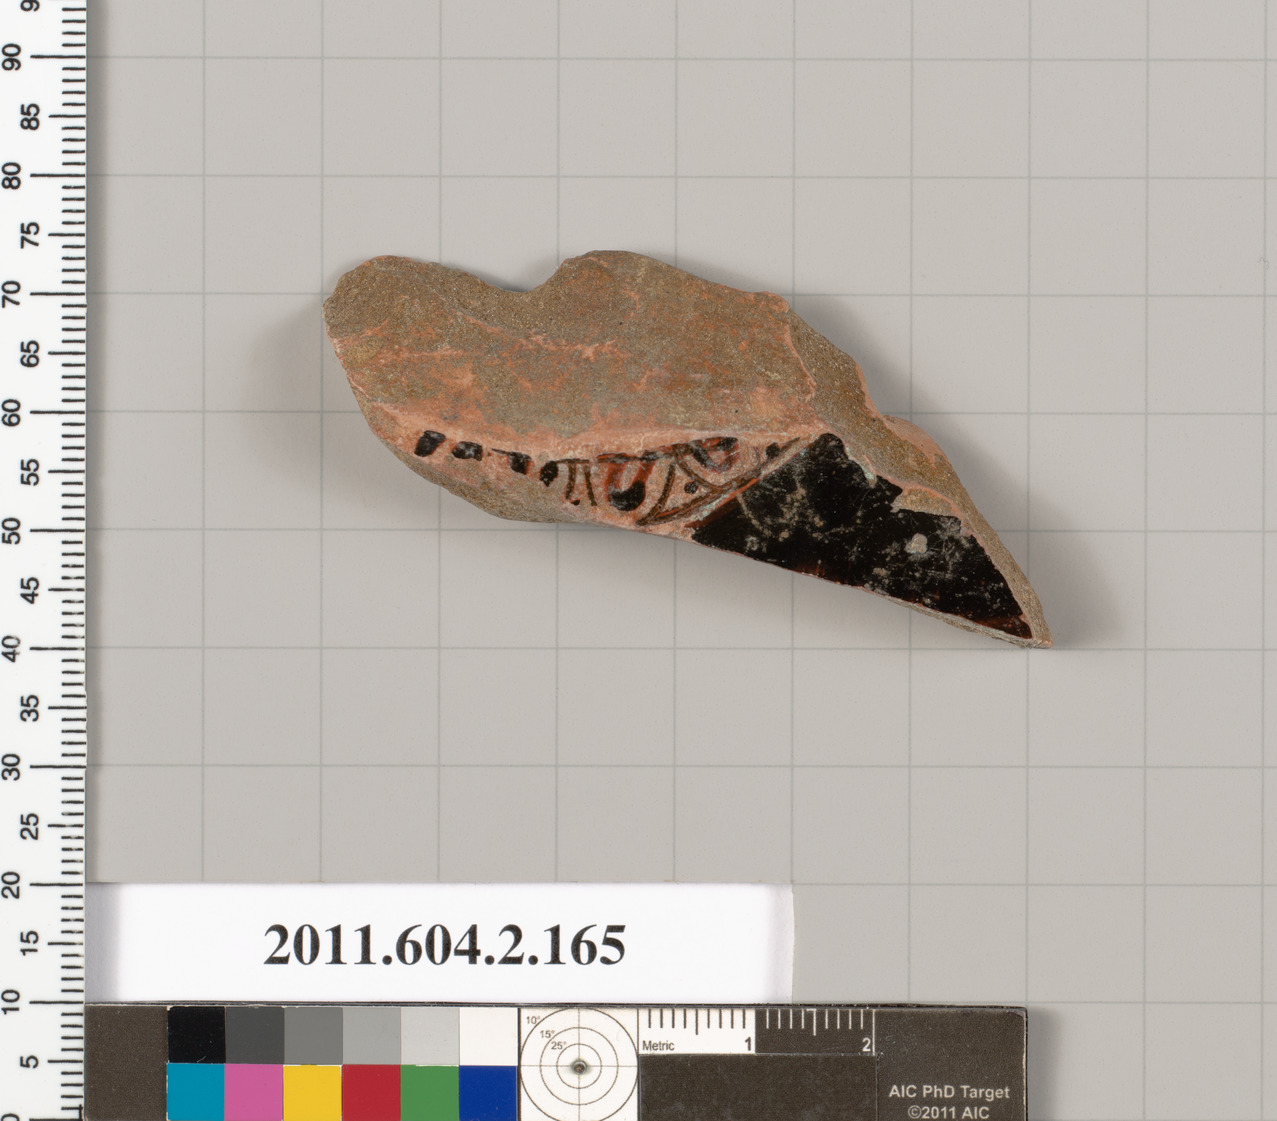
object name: stamnos fragment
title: Terracotta fragment of a stamnos (jar)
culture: greek, attic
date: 450-430 BCE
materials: terracotta